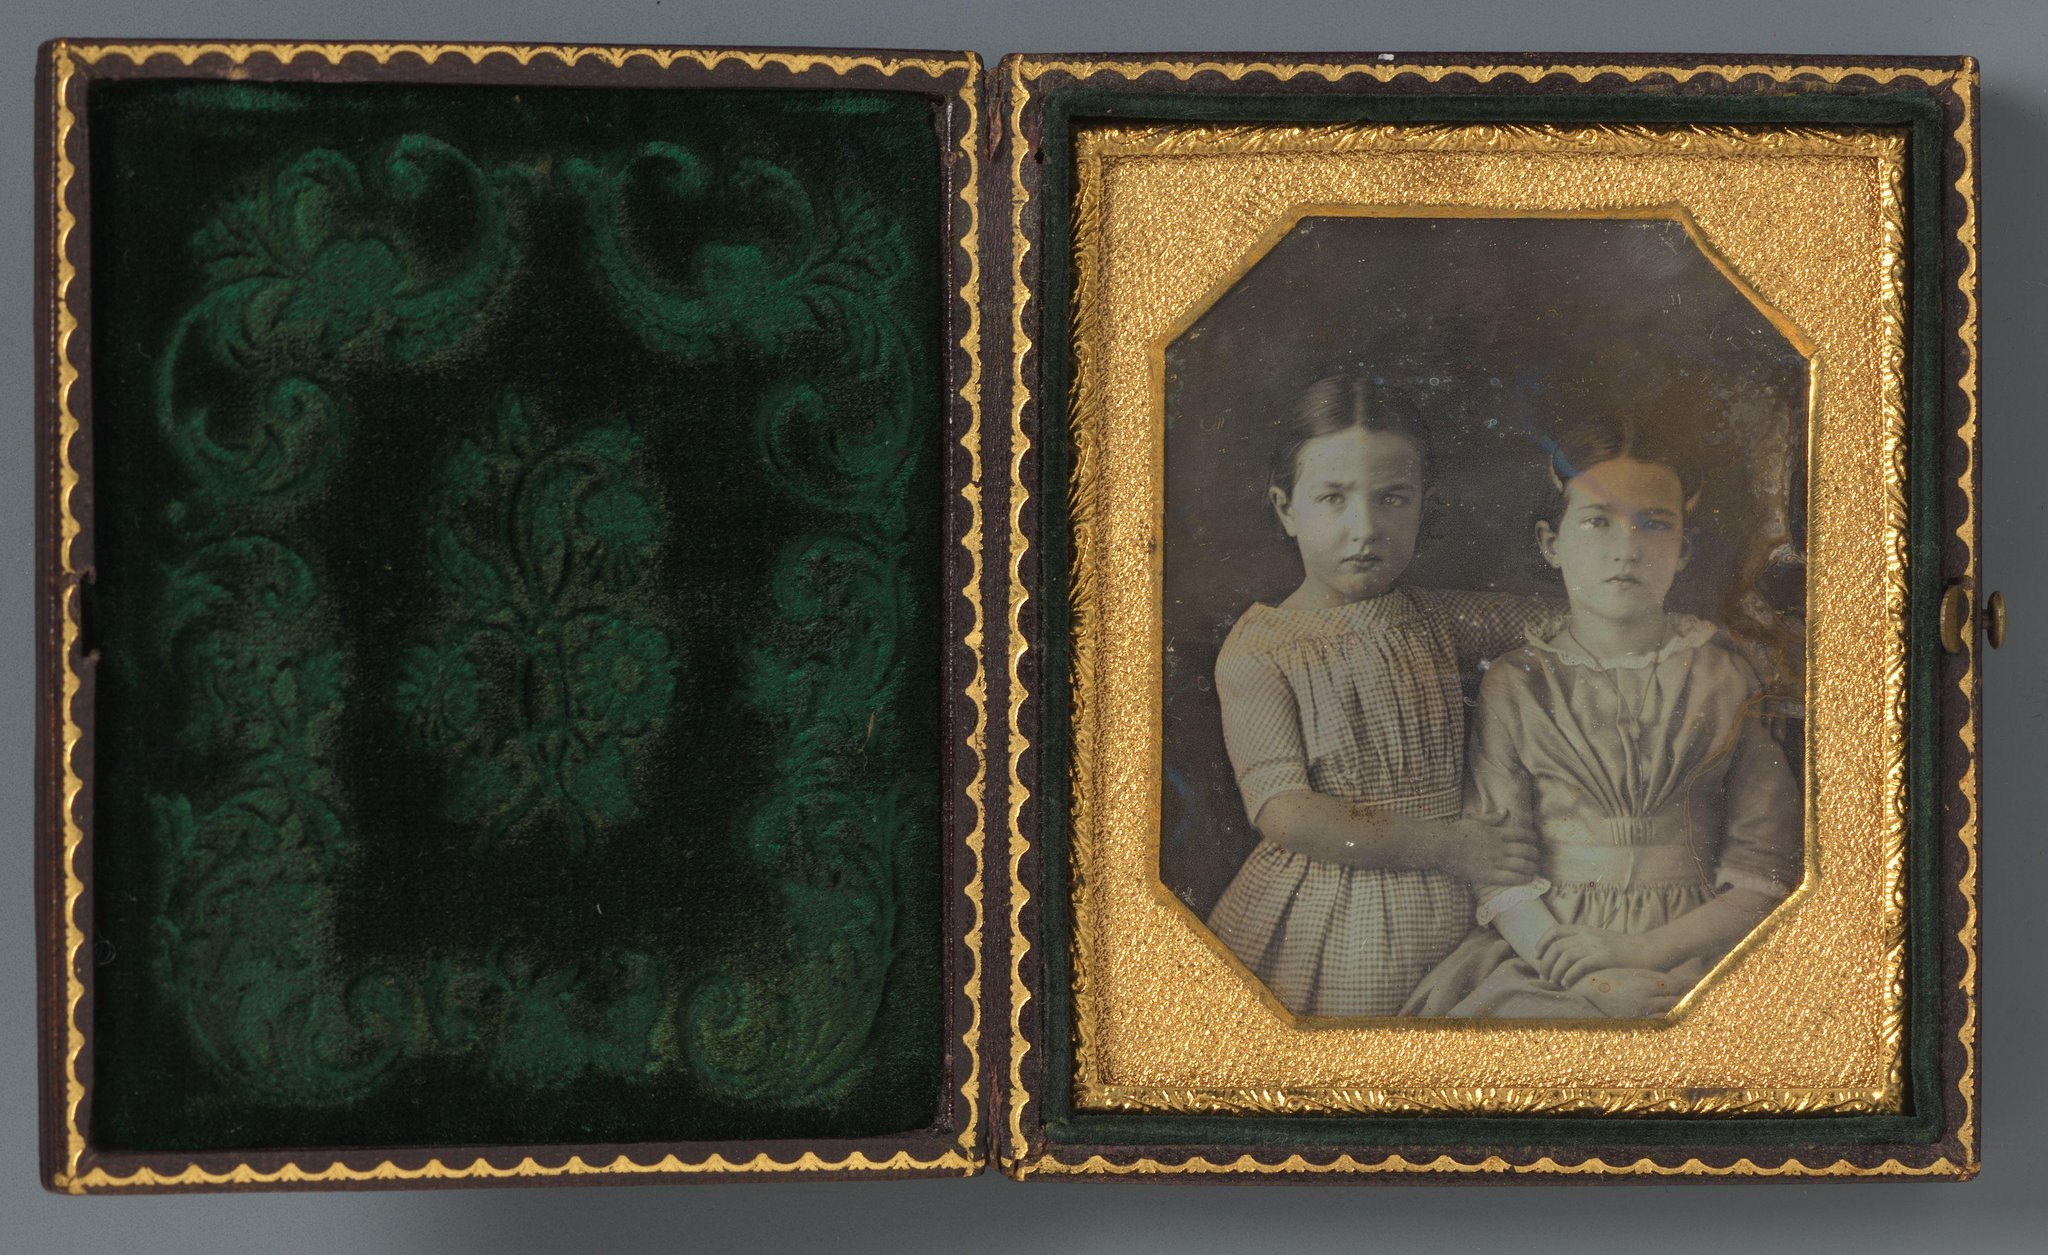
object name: photograph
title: Portret van twee onbekende meisjes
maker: Anonymous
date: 1857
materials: copper, glass, leather, velvet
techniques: daguerreotype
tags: historical persons, girl (child between toddler and youth)